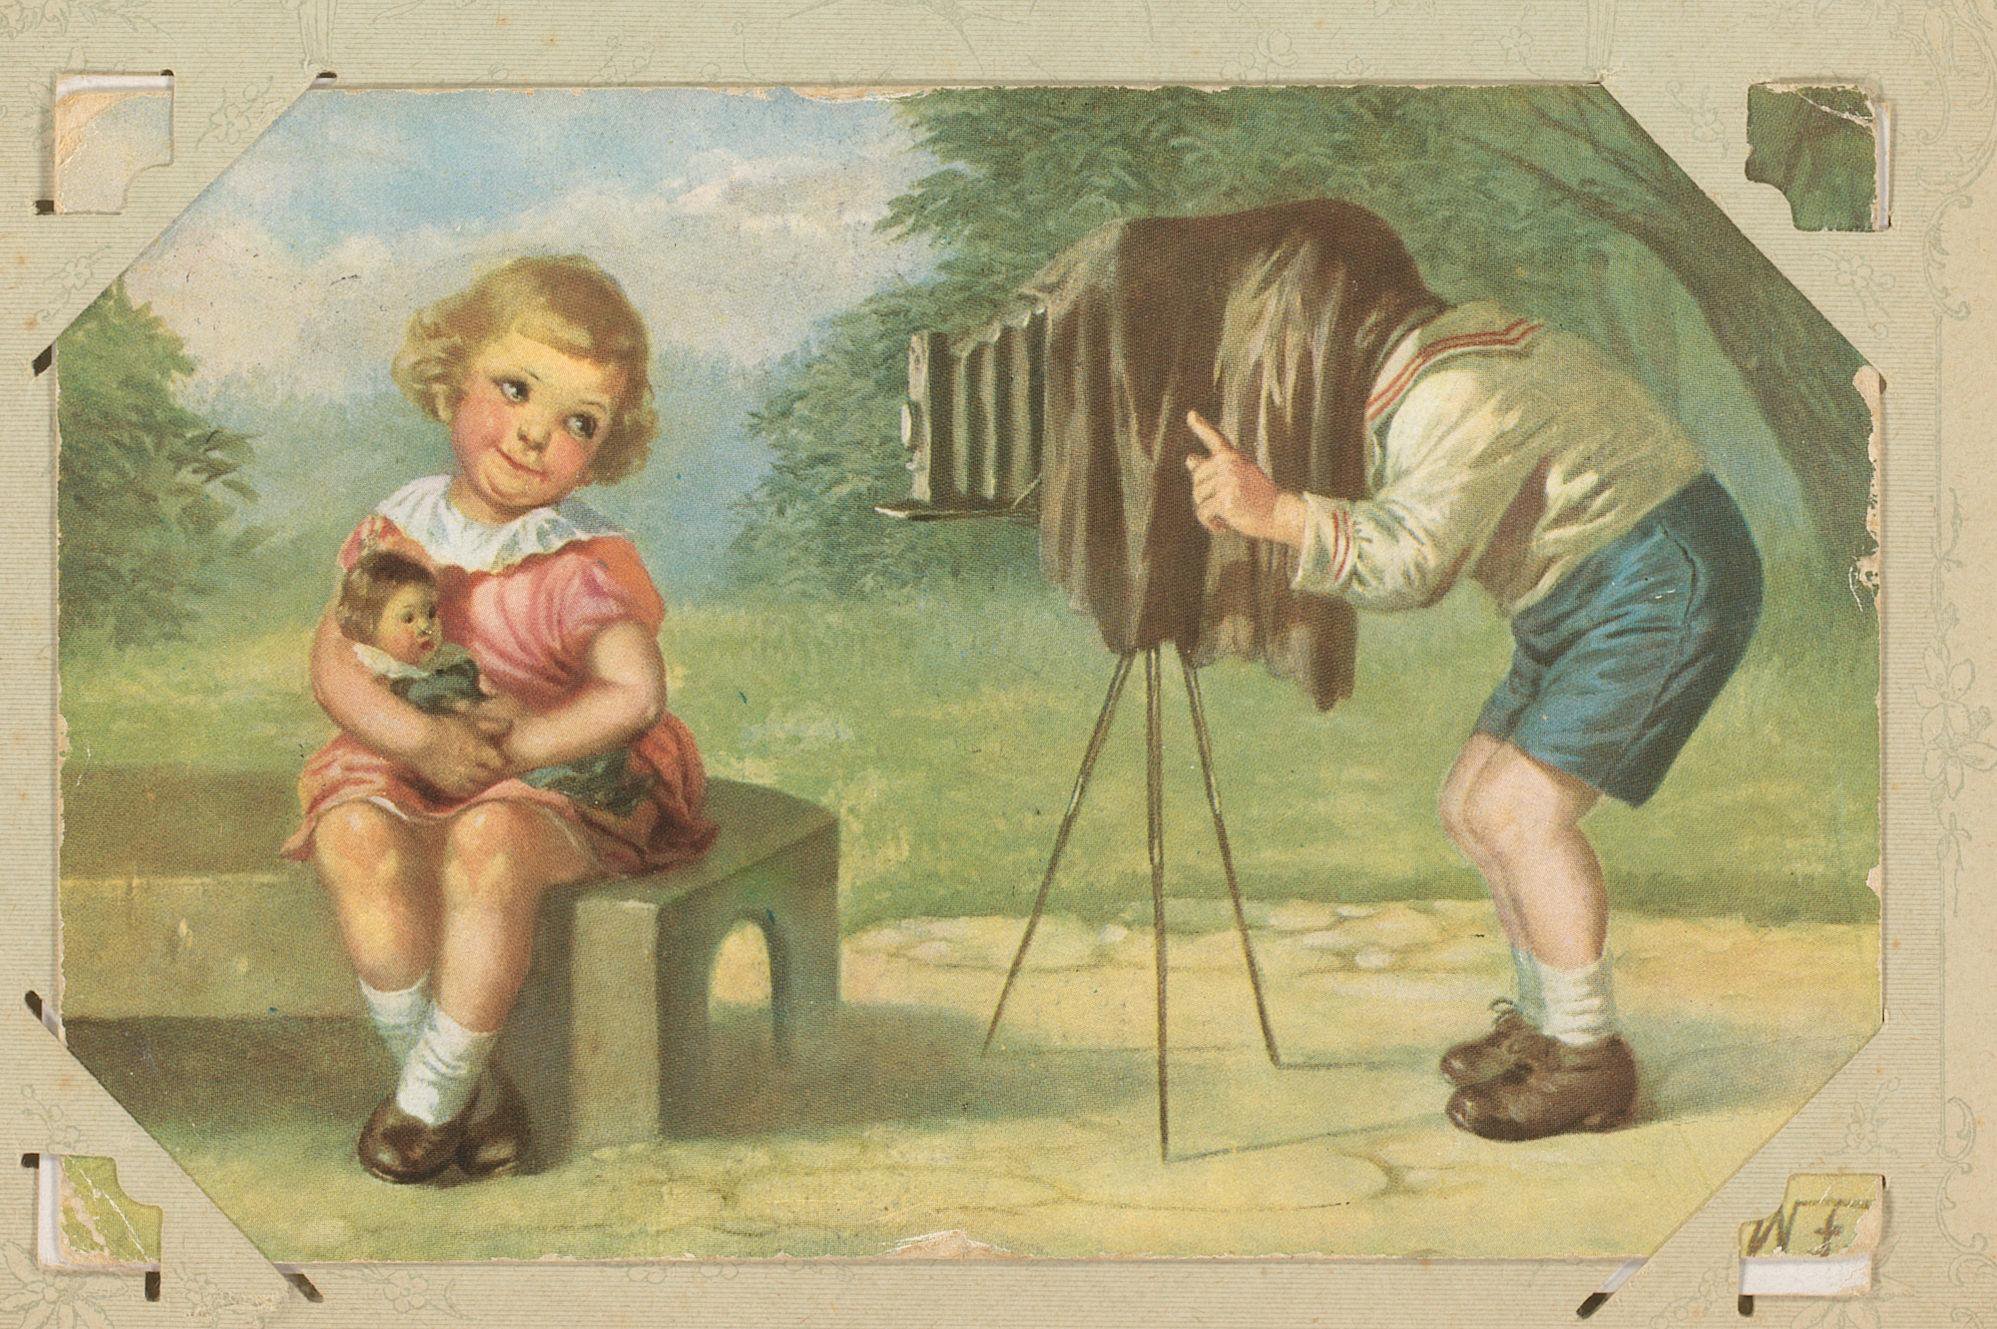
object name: album leaf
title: Jongen maakt een portret van een meisje met pop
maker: Anonymous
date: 1900-1950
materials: cardboard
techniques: four-color autotype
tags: boy (child between toddler and youth), taking photographs, girl (child between toddler and youth), (playing with) dolls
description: Deze prent maakt deel uit van een album.